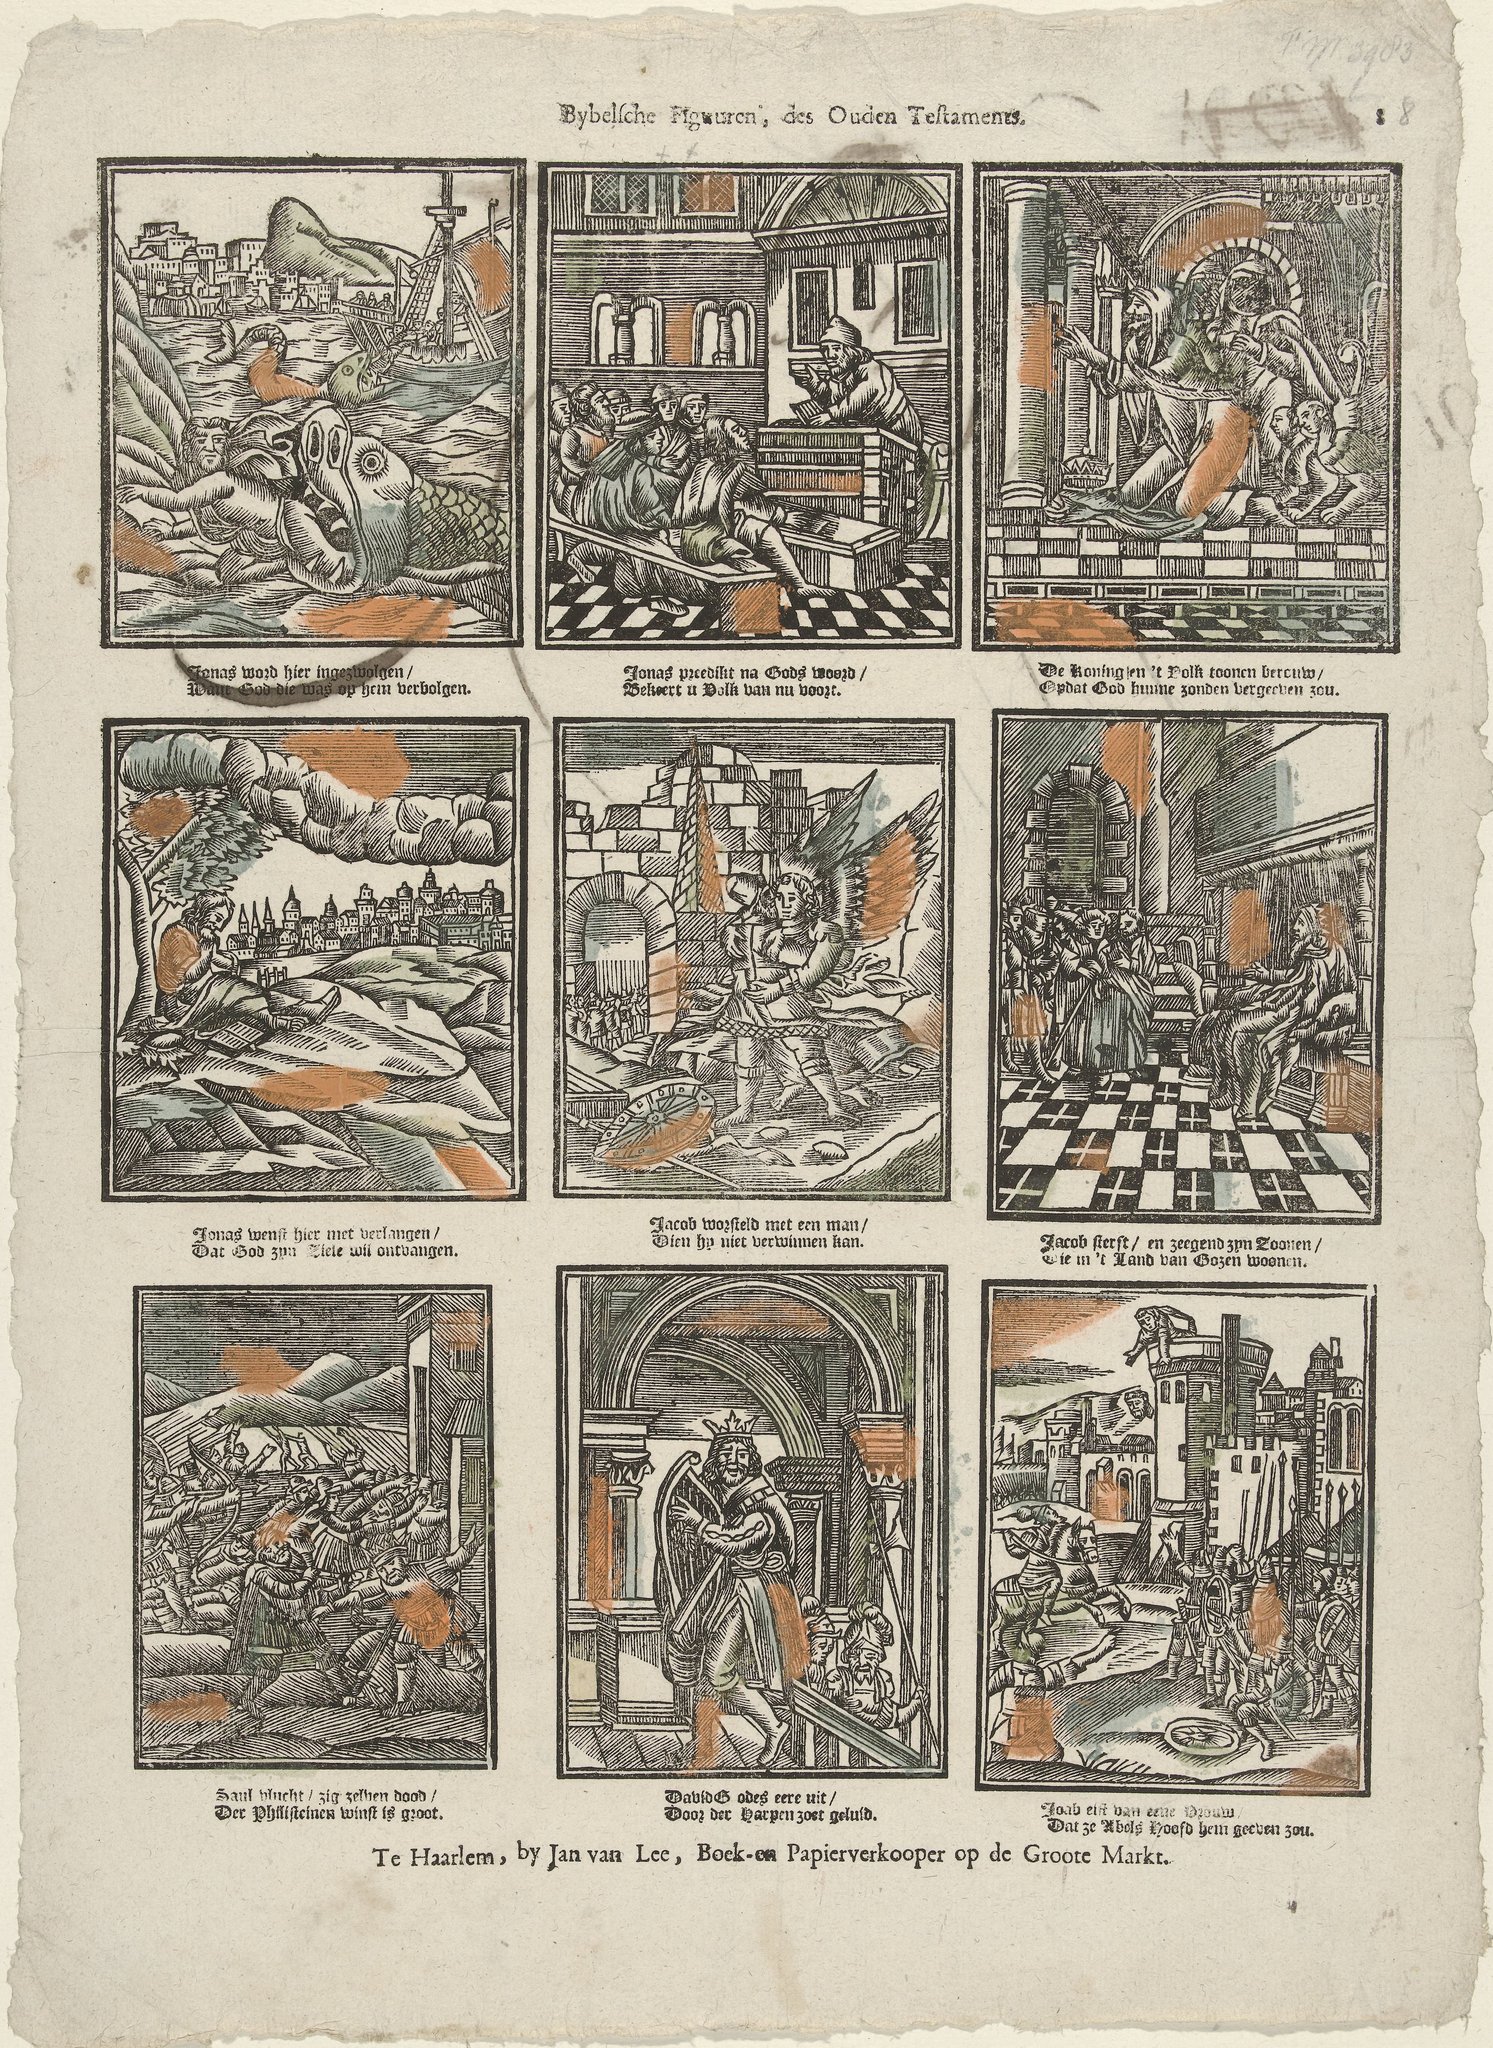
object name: popular print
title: Bybelsche Figuuren, des Ouden Testaments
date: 1739-1786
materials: paper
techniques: colour, letterpress printing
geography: netherlands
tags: old testament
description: Blad met 9 voorstellingen van verhalen uit het Oude Testament, van Jona tot Joab. Onder elk plaatje een tweeregelig versje. Genummerd: 8.